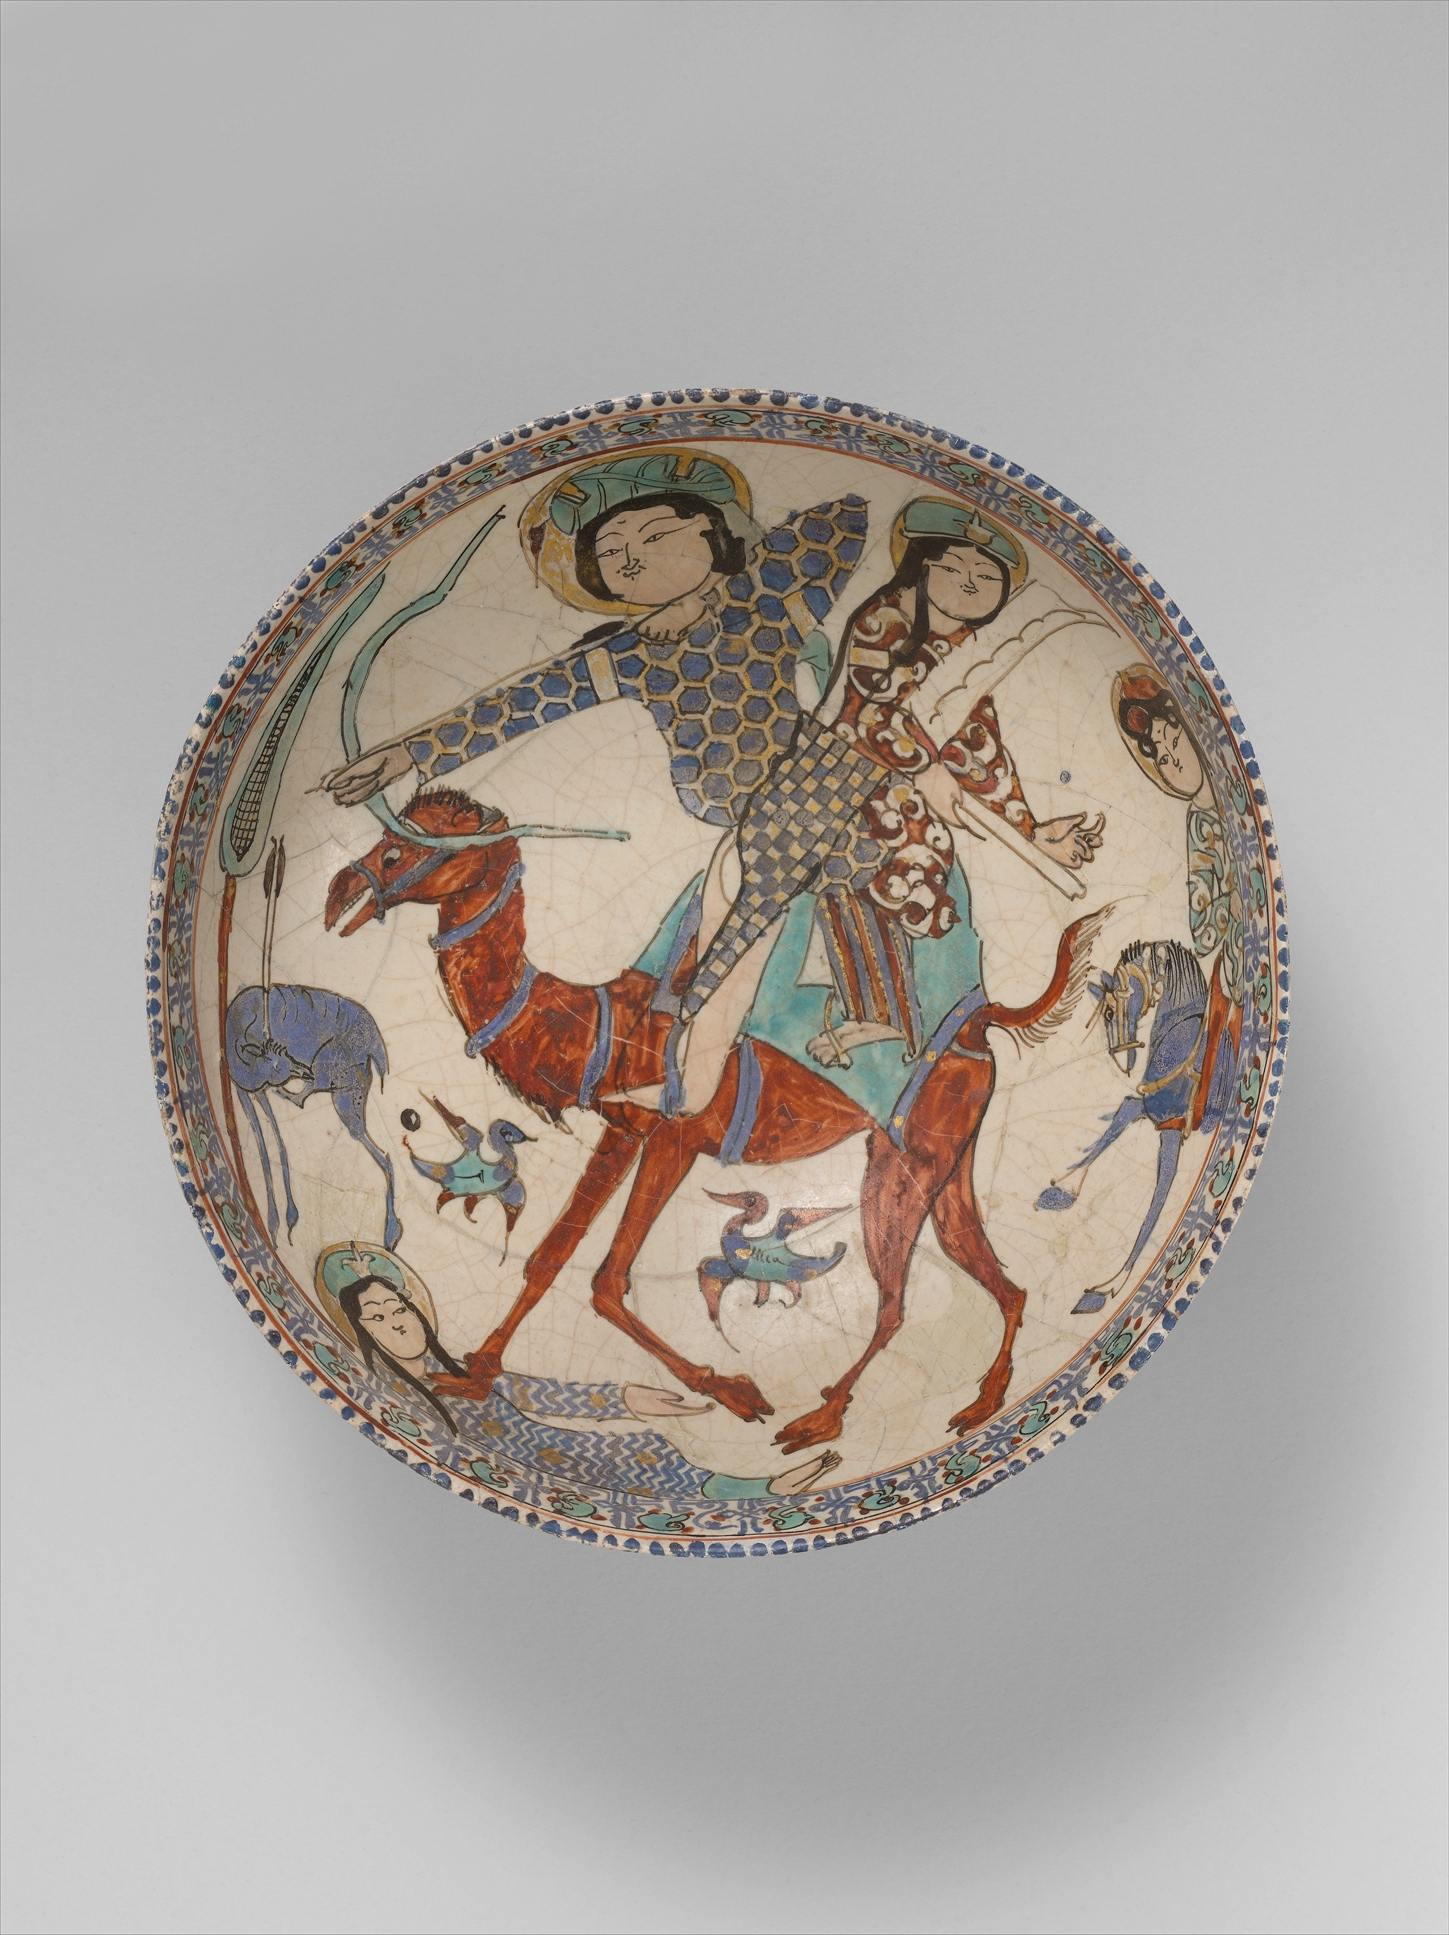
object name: bowl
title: Bowl with Bahram Gur and Azada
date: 1167-1233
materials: glaze, stonepaste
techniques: gilding, glazing, overglaze, painting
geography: iran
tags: men,women,hunting,camels